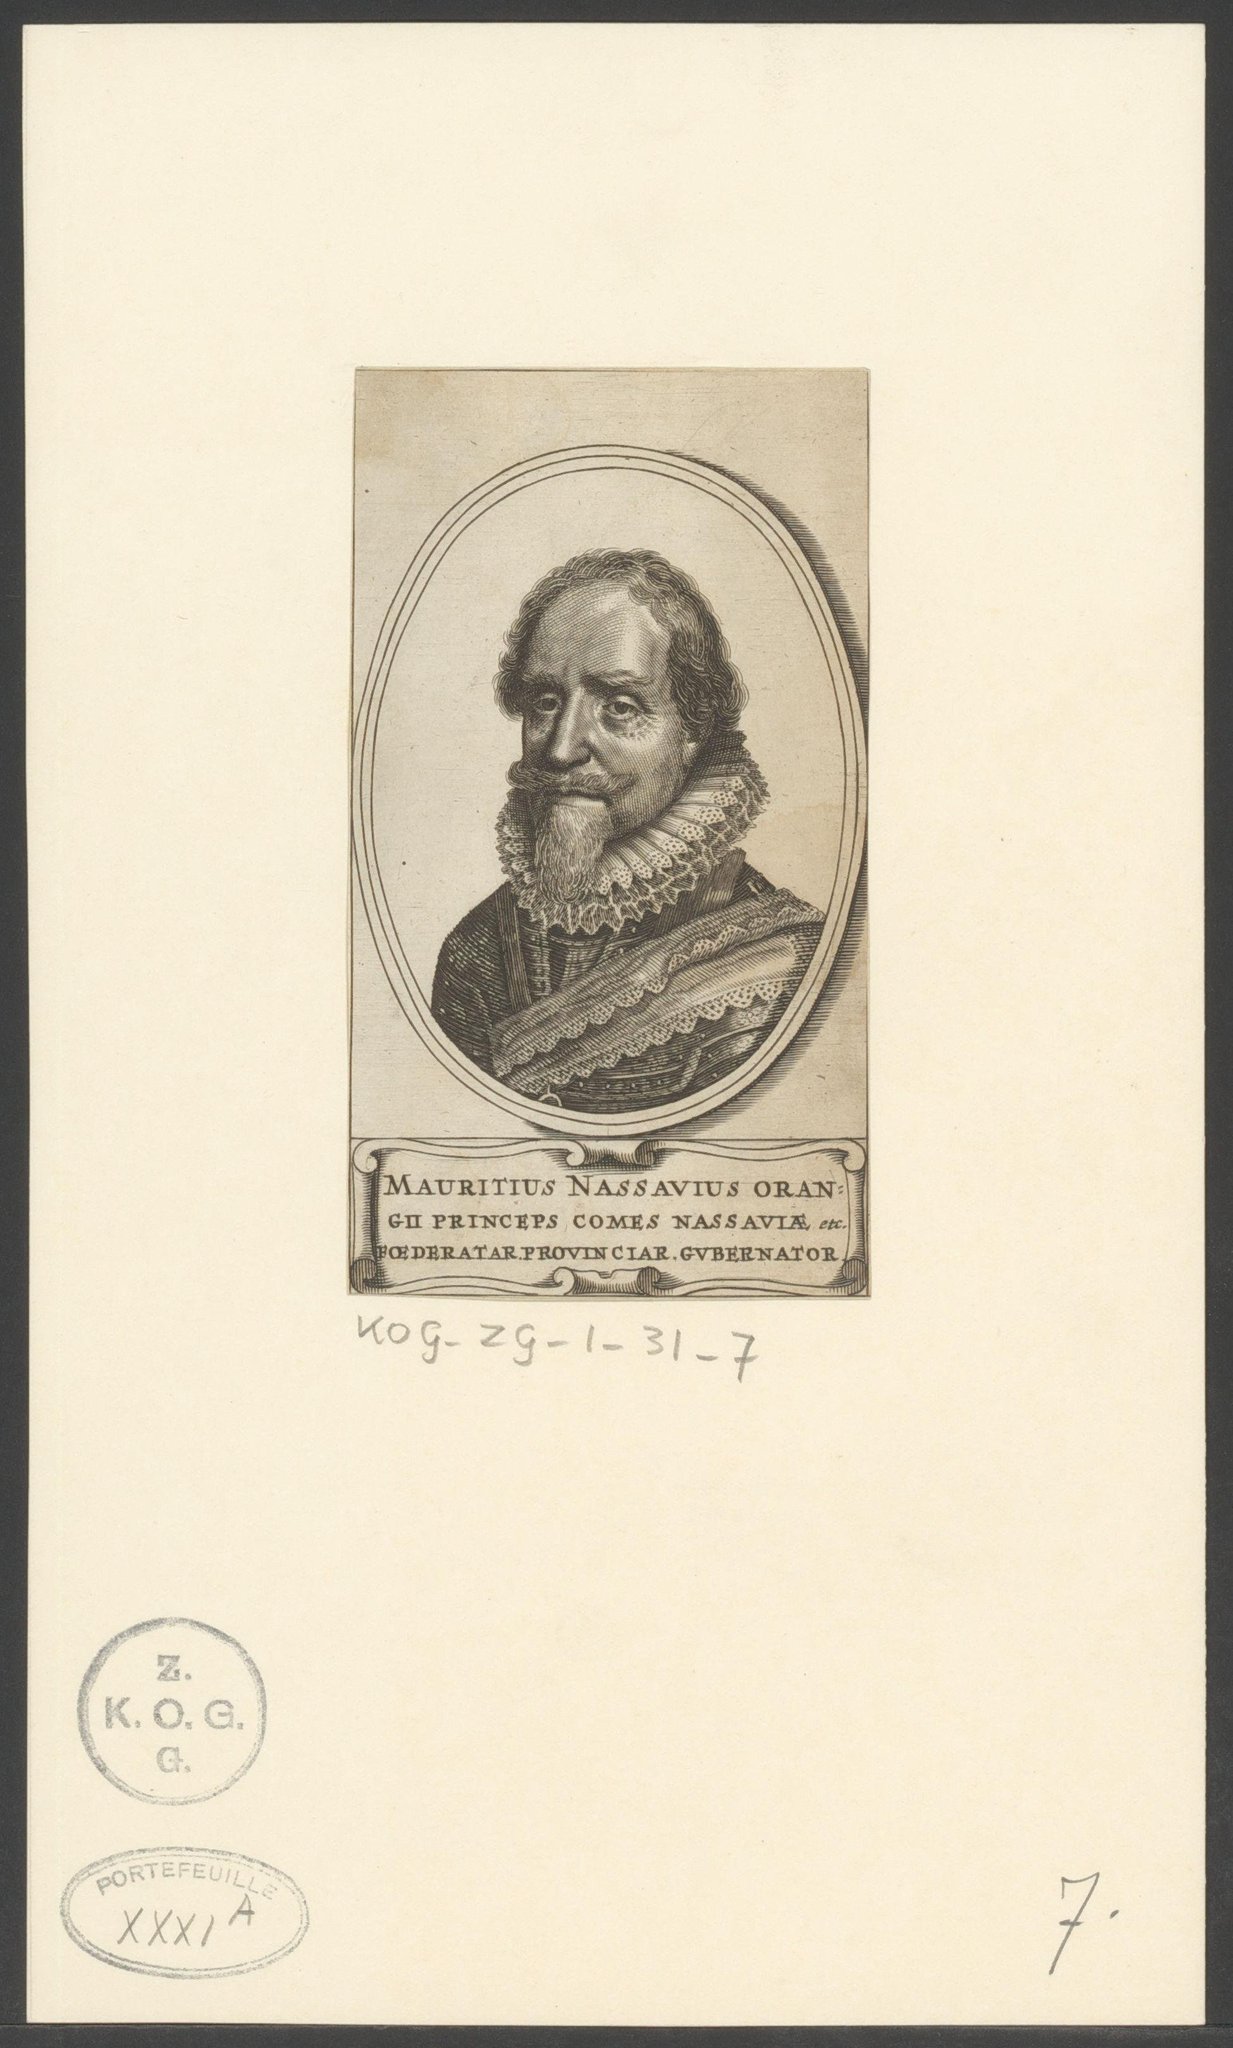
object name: print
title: Portret van Maurits, prins van Oranje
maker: Anonymous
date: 1648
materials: paper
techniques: engraving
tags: the hague, maurice (prince of orange), historical persons, knighthood order (garter)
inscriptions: collector's mark: Lugt 1641, stamp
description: Onderwerpsrubrieken binnen de Atlas Zeden en Gewoonten: Portretten, Portretten van Vorsten uit het huis van Oranje, Regeerende Vorsten, Stadhouders van Holland, Zeeland en West-Friesland.